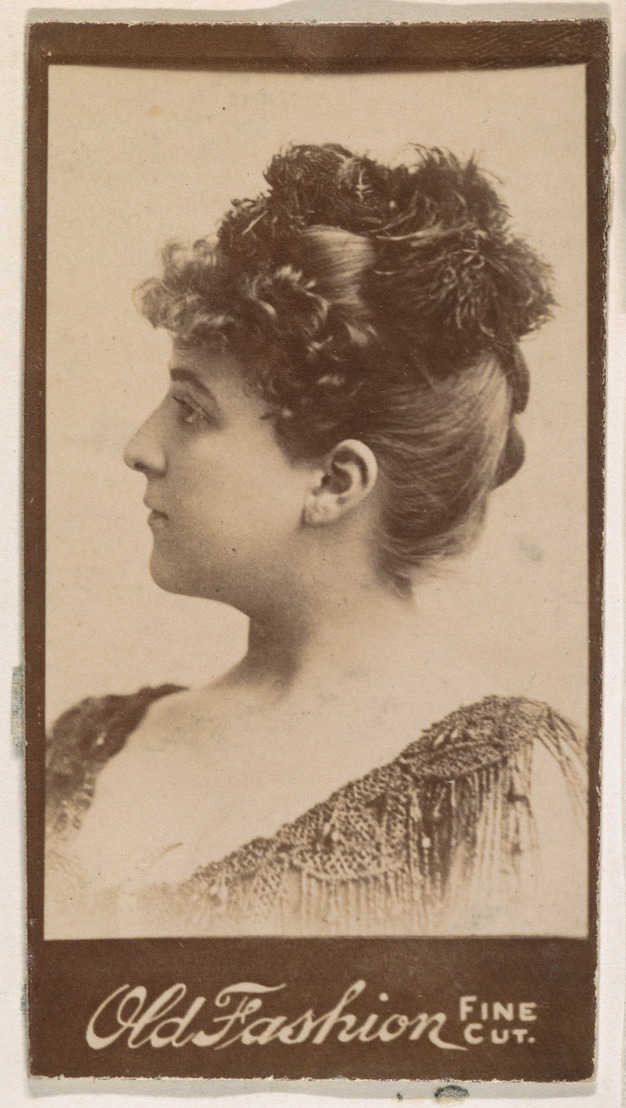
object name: photograph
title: Portrait of actress in profile, from the Actresses series (N664) promoting Old Fashion Fine Cut Tobacco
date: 1888-1890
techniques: albumen silver print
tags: women,actresses